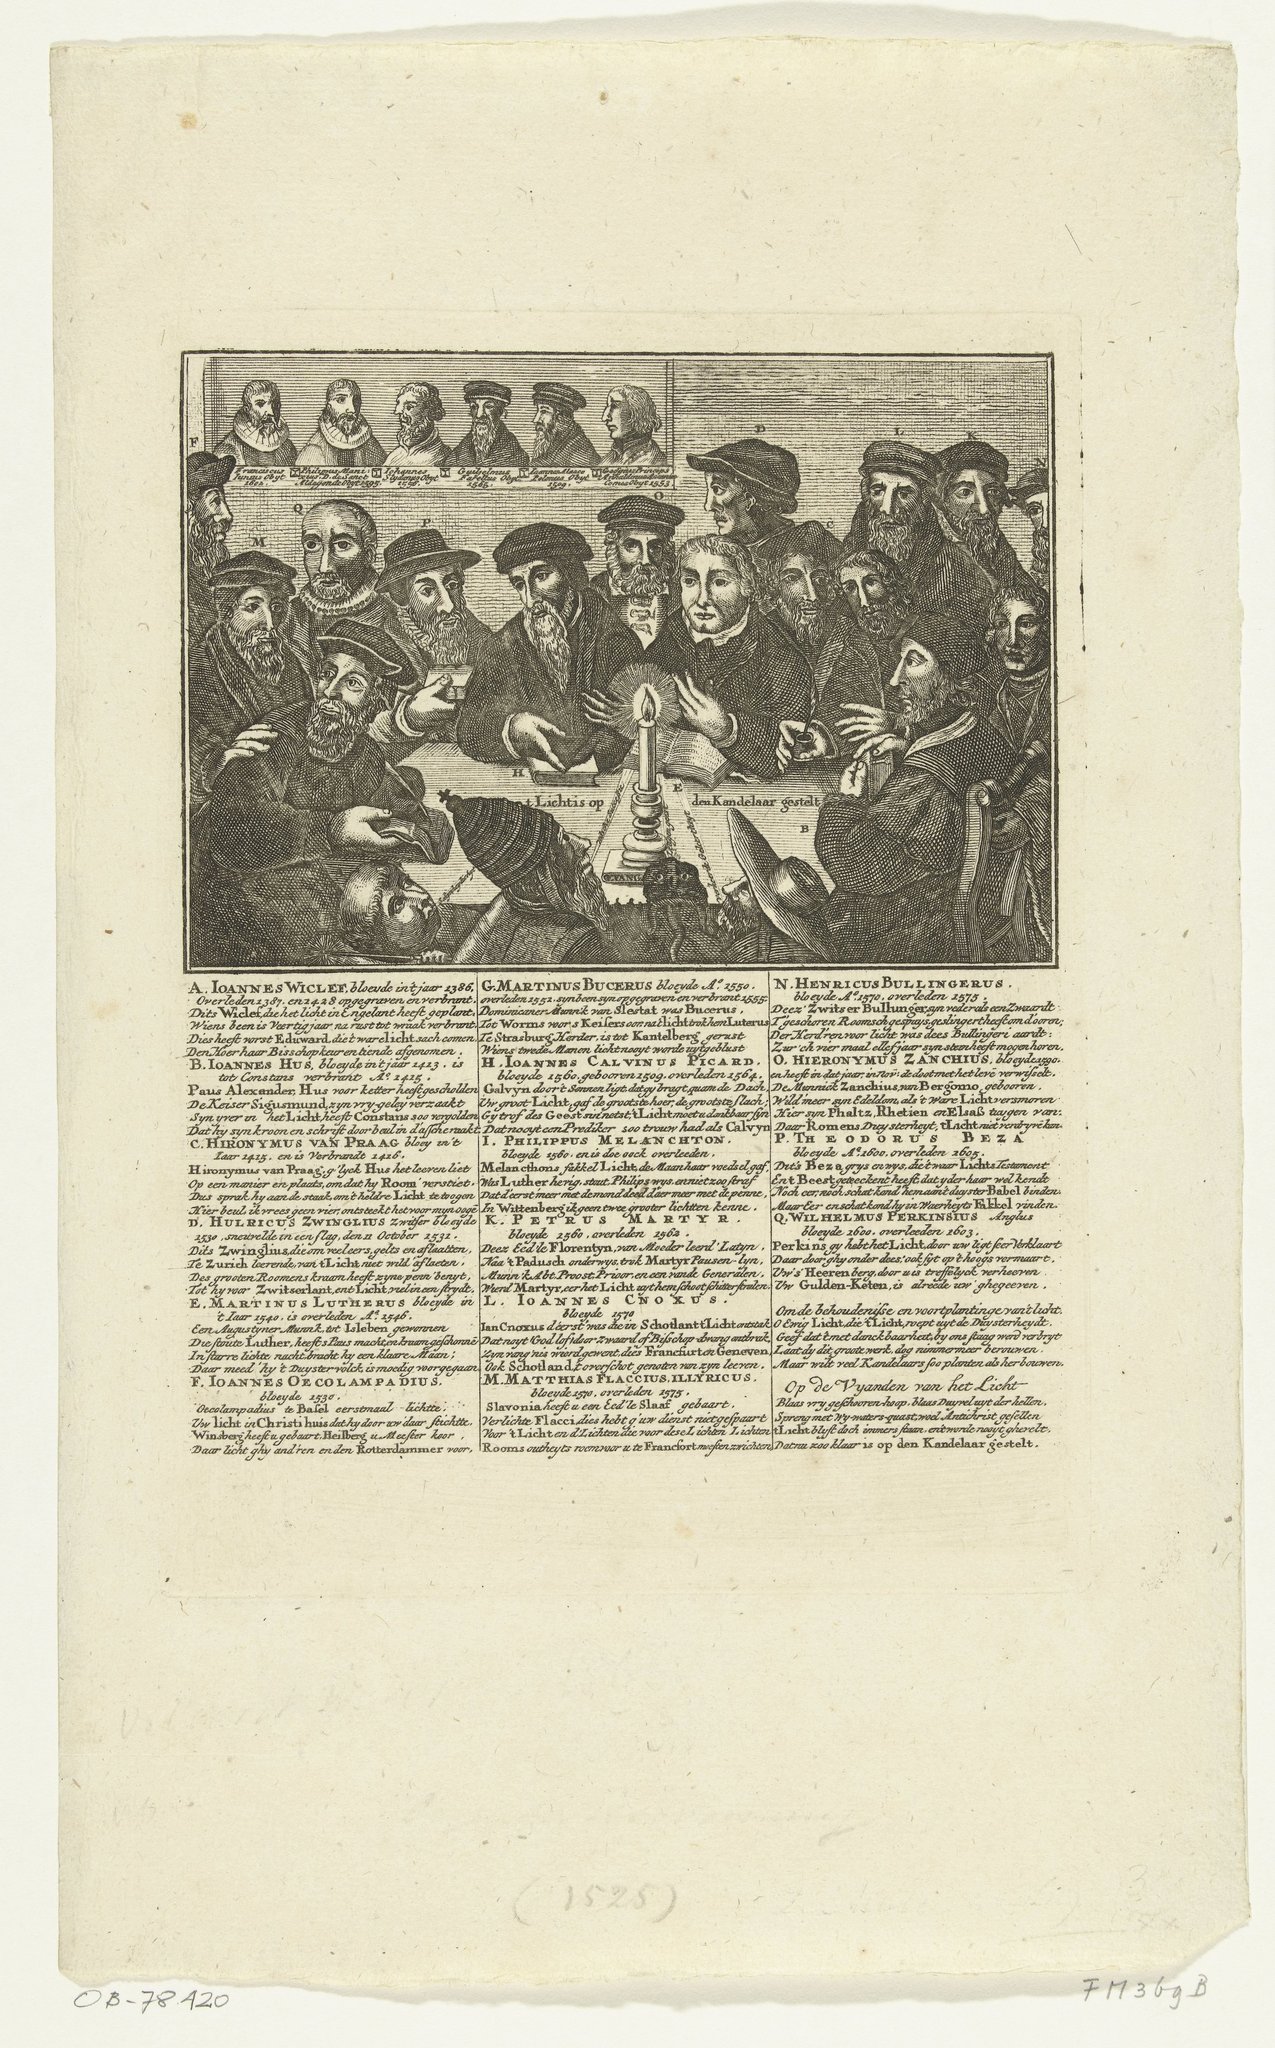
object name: print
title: Het licht is op de kandelaar gestelt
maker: Anonymous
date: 1650-1724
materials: paper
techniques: etching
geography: northern netherlands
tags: theodorus beza, clergyman, prague, priest, martin luther, reformation (roman catholic church vs. protestantism)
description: Anti-roomse spotprent met een groep van reformatoren gezeten om een tafel waarop een brandende kaars staat. De kandelaar staat op een boek aangeduid als de Evangelie. De duivel, de paus, een kardinaal en een monnik proberen tevergeefs de kaars uit te blazen. De figuren zijn met letters aangeduid die in het onderschrift, drie kolommen Nederlands, worden verklaard.